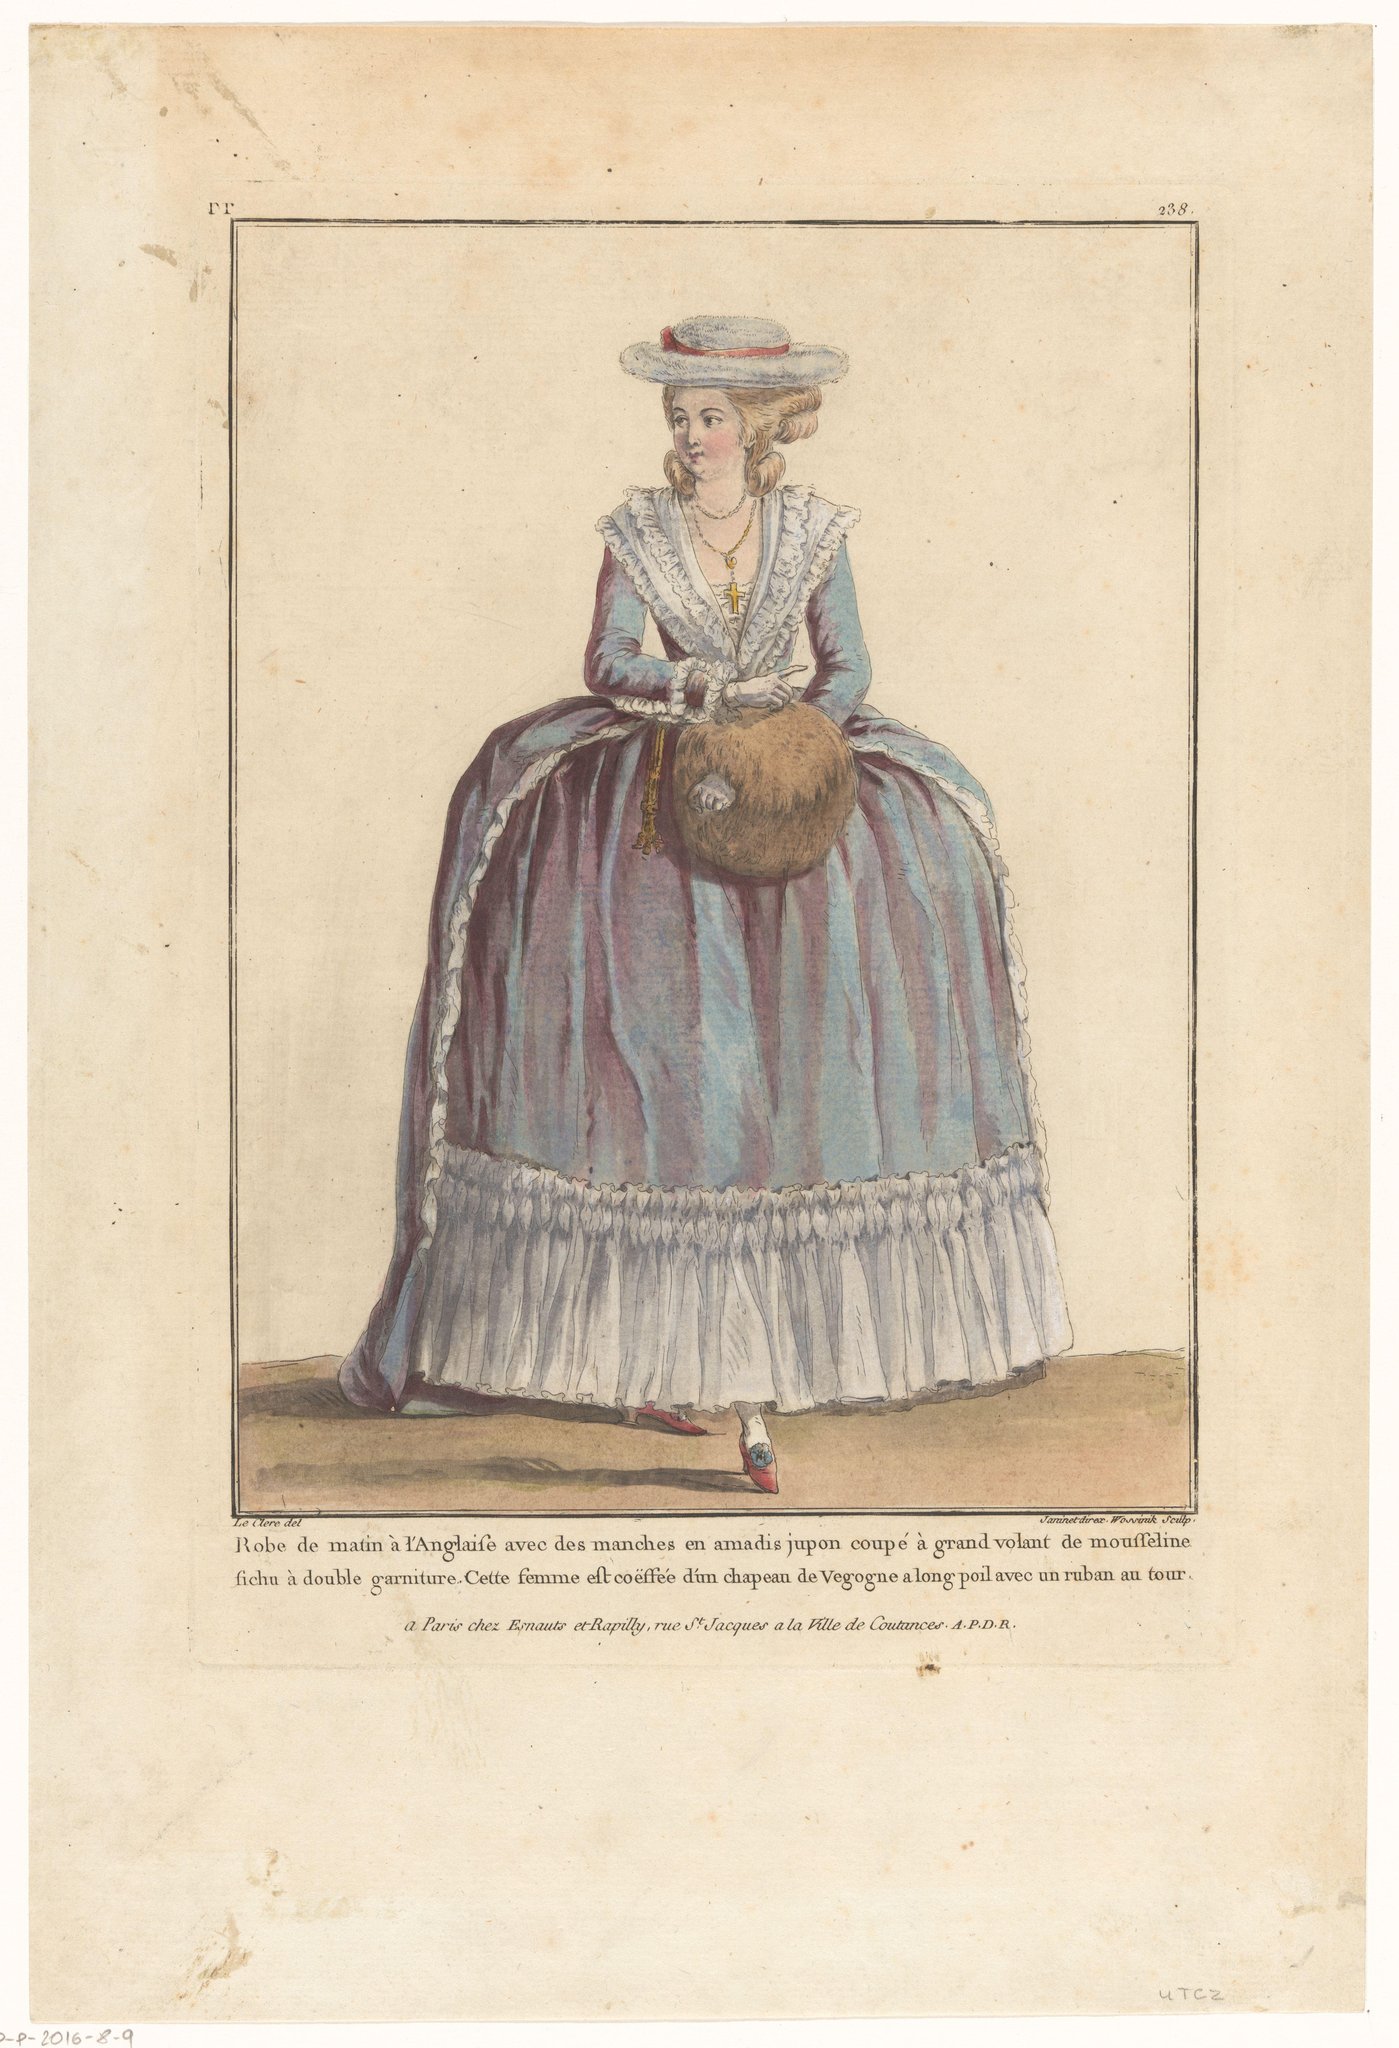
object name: fashion print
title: Gallerie des Modes et Costumes Français, 1782, rr. 238: Robe de matin à l'Anglais (...)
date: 1782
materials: paper, ink, watercolor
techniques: aquatint, etching, hand coloring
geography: paris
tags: pendant, trinket, 'breloque' (+ women's clothes), dress, gown: morning dress (+ women's clothes), dress, gown: robe à l'anglaise (+ women's clothes), fashion plates, head-gear: hat (+ women's clothes), shoes, sandals (+ women's clothes), piece of clothing covering the breast or décolleté (fichu) (+ women's clothes), necklace (+ women's clothes), muff (+ women's clothes)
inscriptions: title (possibly false): ‘Robe de matin à l'Anglaise avec des manches en amadis. jupon coupé à grand volant de mousseline. fichu à double garniture. Cette femme est coëffée d'un chapeau de Vergogne a long poil avec un ruban au tour.’, collector's mark: Lugt 2228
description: Ochtendjapon (Robe à l'Anglaise) van mousseline met brede geplooide strook aan de onderrand. Fichu met dubbele geplooide rand. Eenvoudig plat hoedje met lint om de bol. Mof om de linkerpols. Ketting met kruisje. Prent uit serie rr. 34e Cahier de Costumes Français, 31e Suite d'Habillemens à la mode en 1782, Gallerie des Modes et Costumes Français.